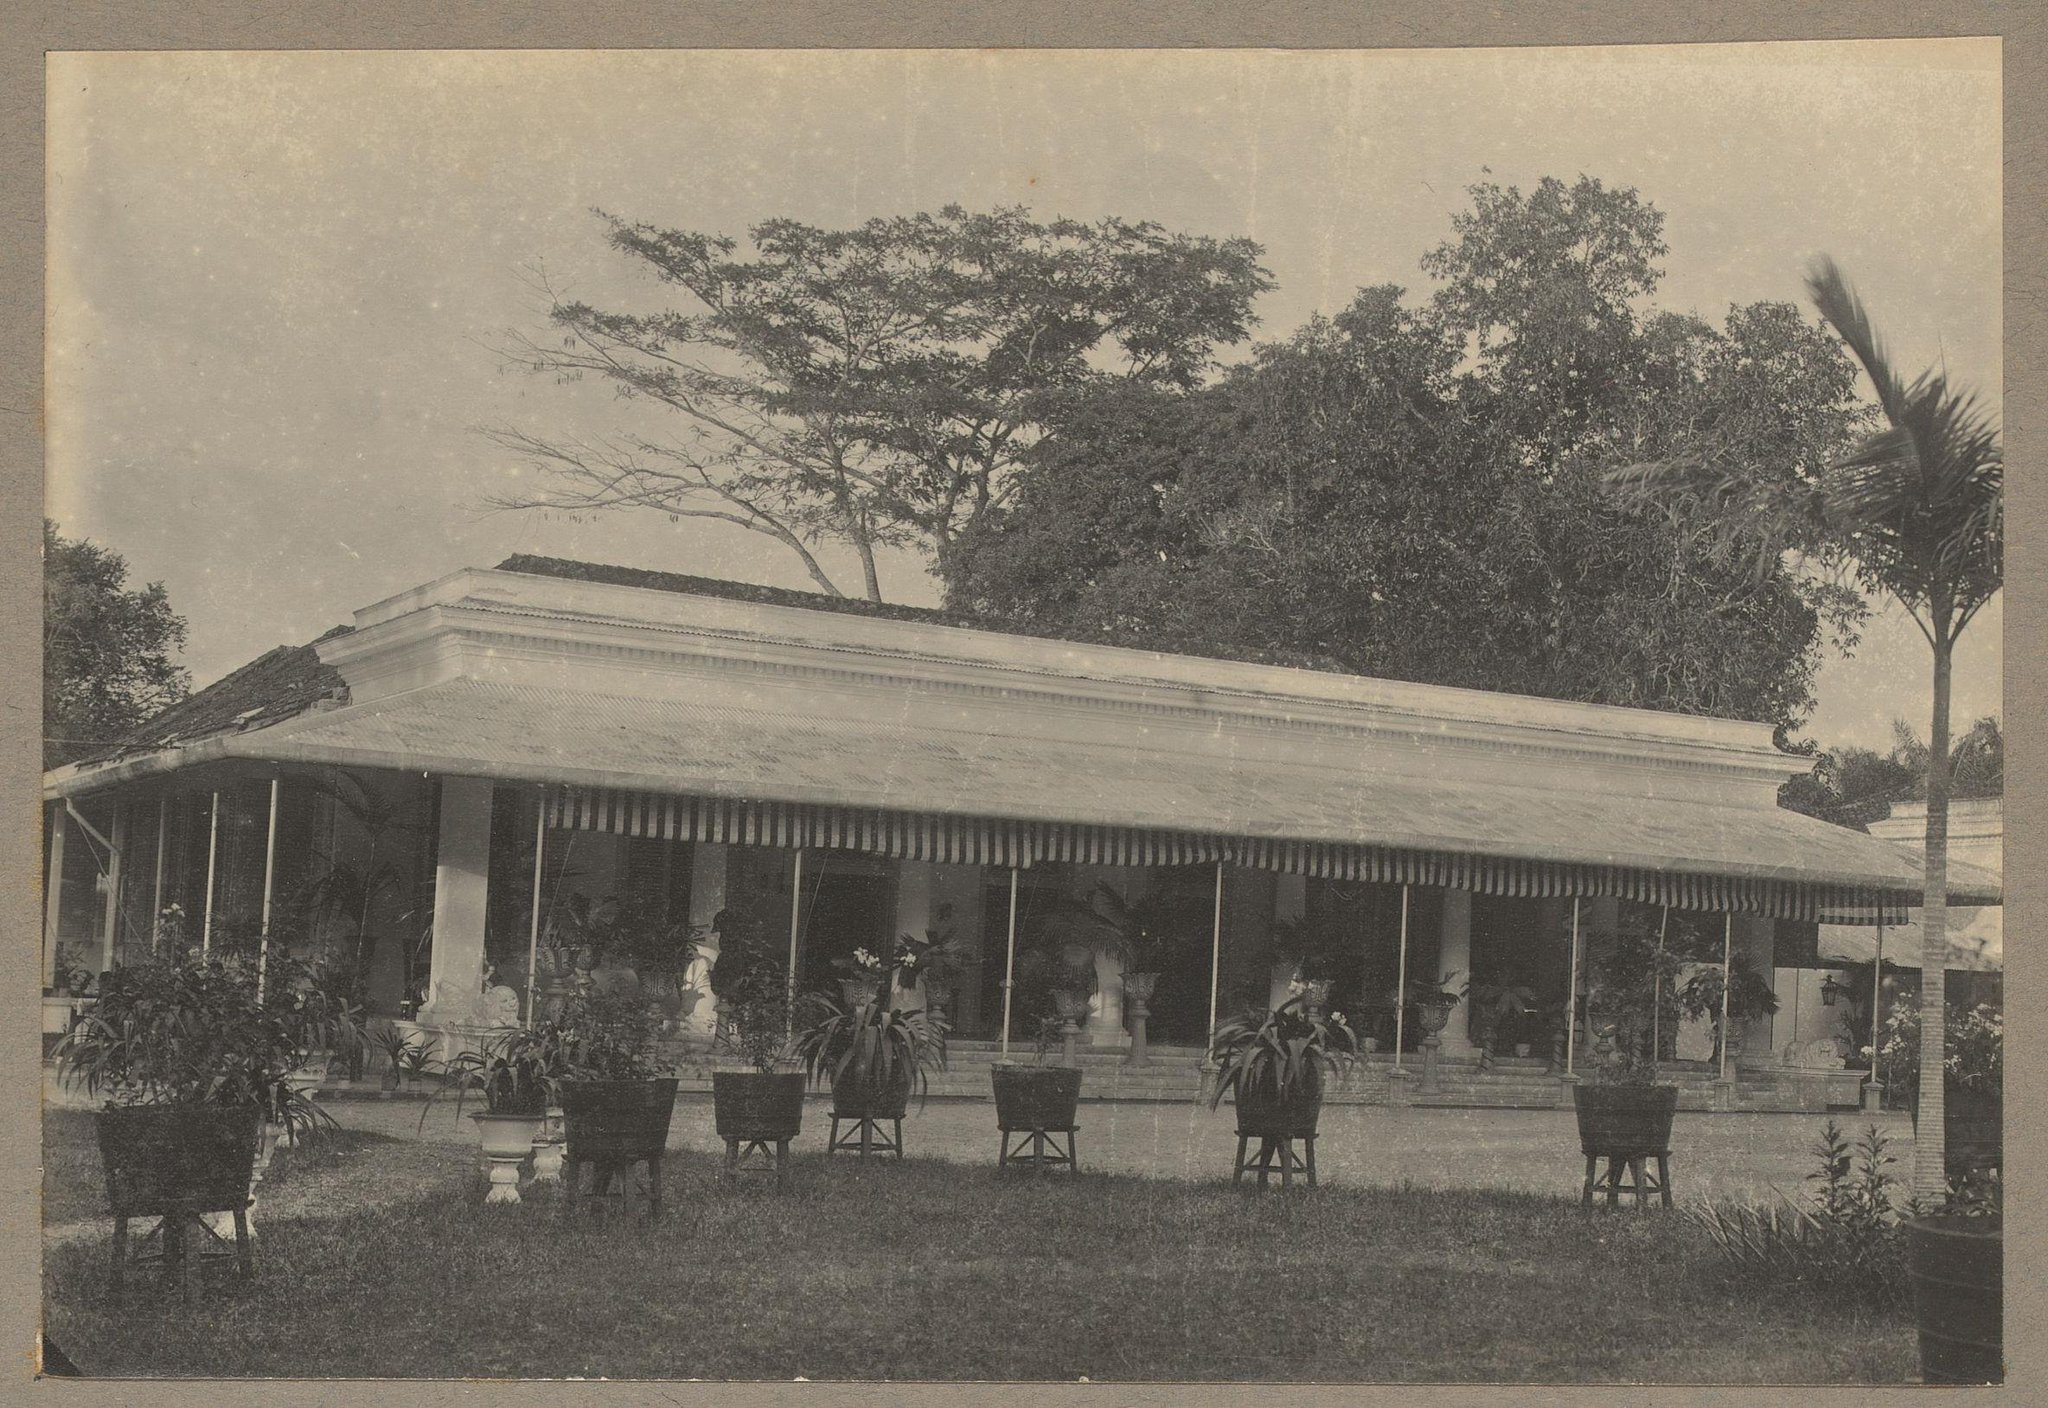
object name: photograph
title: Oud residentswoning, thans woning van den Chef der Banka-tinwinning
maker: Anonymous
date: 1914-1919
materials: photographic support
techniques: gelatin silver print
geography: bangka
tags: robert julius boers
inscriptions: inscription: ‘Oud residentswoning, thans woning van den Chef der Banka-tinwinning’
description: De woning van de chef van het hoofdbureau van de Banka-tinwinning te Muntok. Onderdeel van het fotoalbum aangeboden aan Robert Julius Boers bij zijn vertrek naar Nederland in 1919 door het personeel van de Banka-tinwinning.